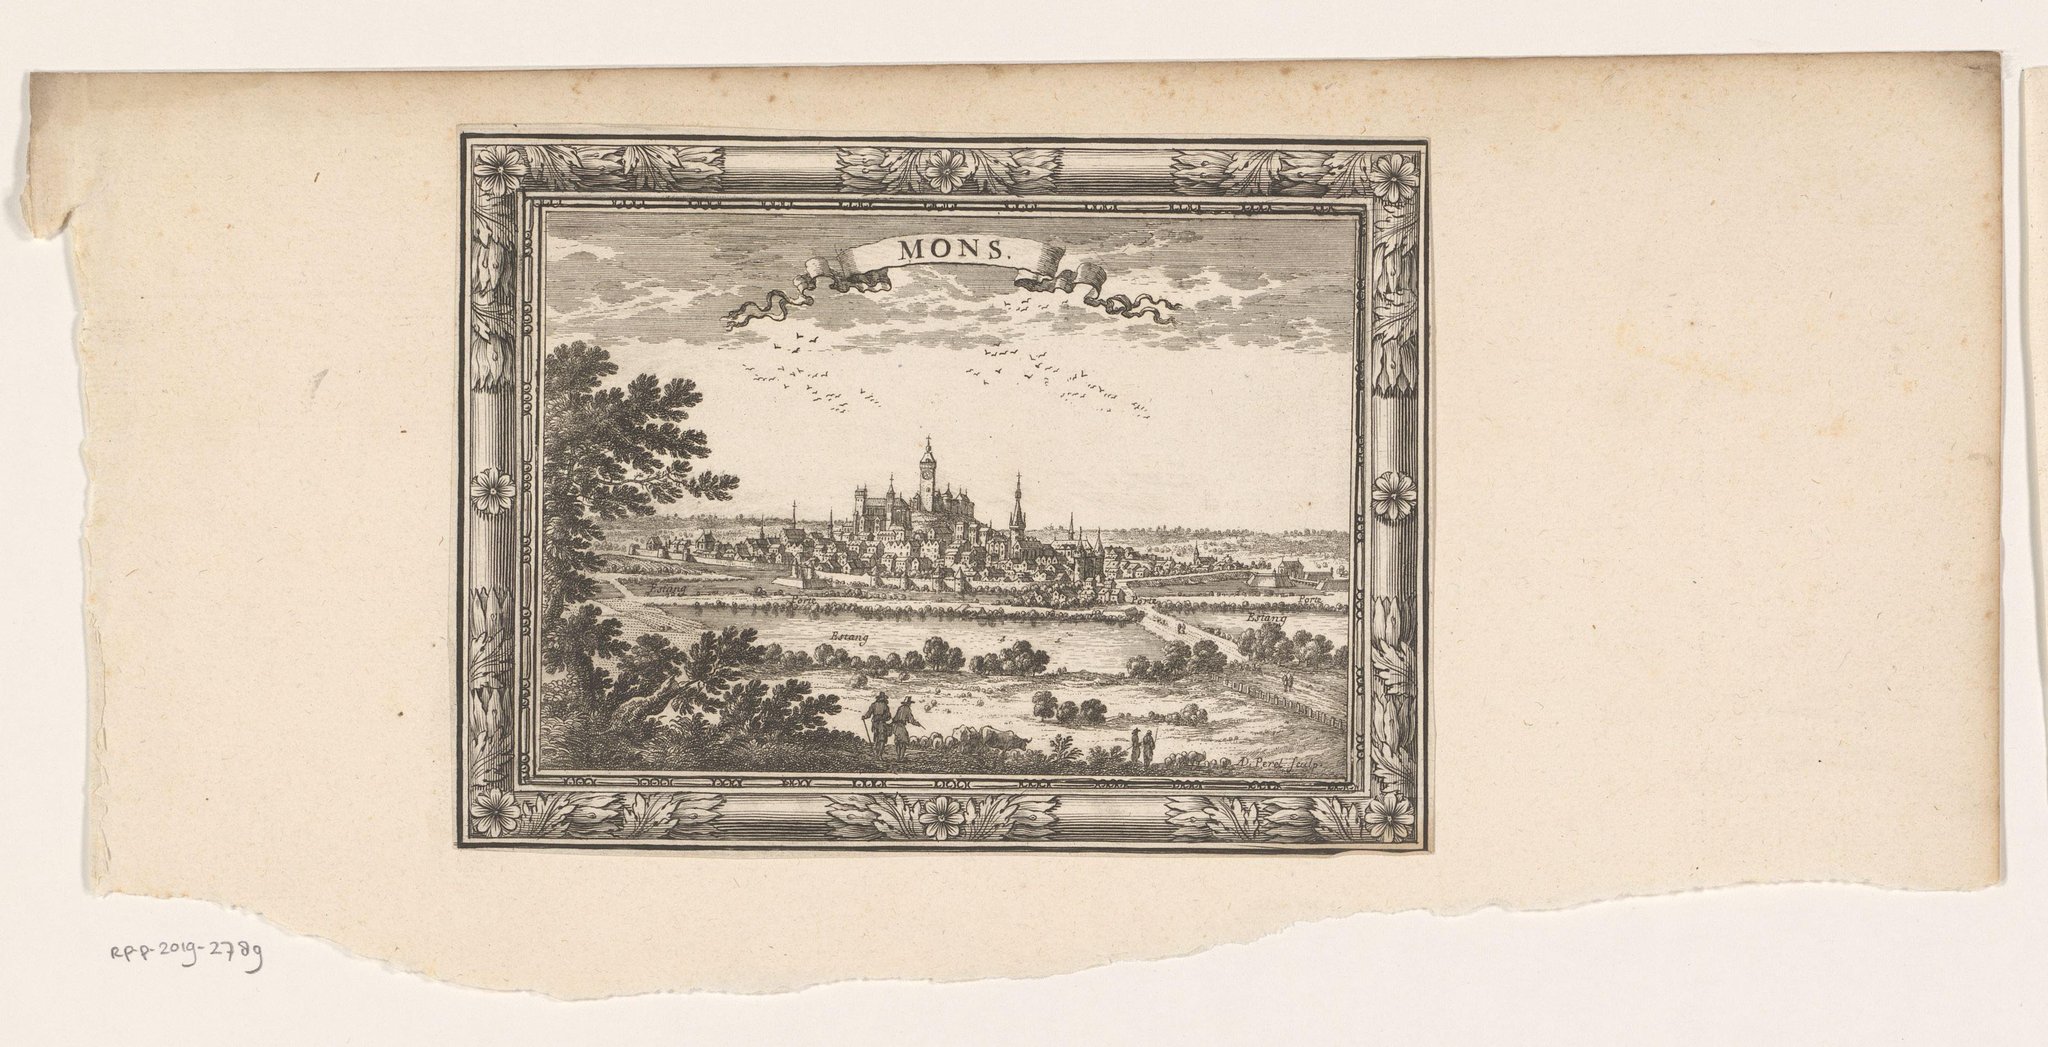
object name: print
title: Mons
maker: adam perelle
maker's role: draughtsman, print maker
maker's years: 1638-1695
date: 1648-1695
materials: paper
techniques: etching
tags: city-view, and landscape with man-made constructions